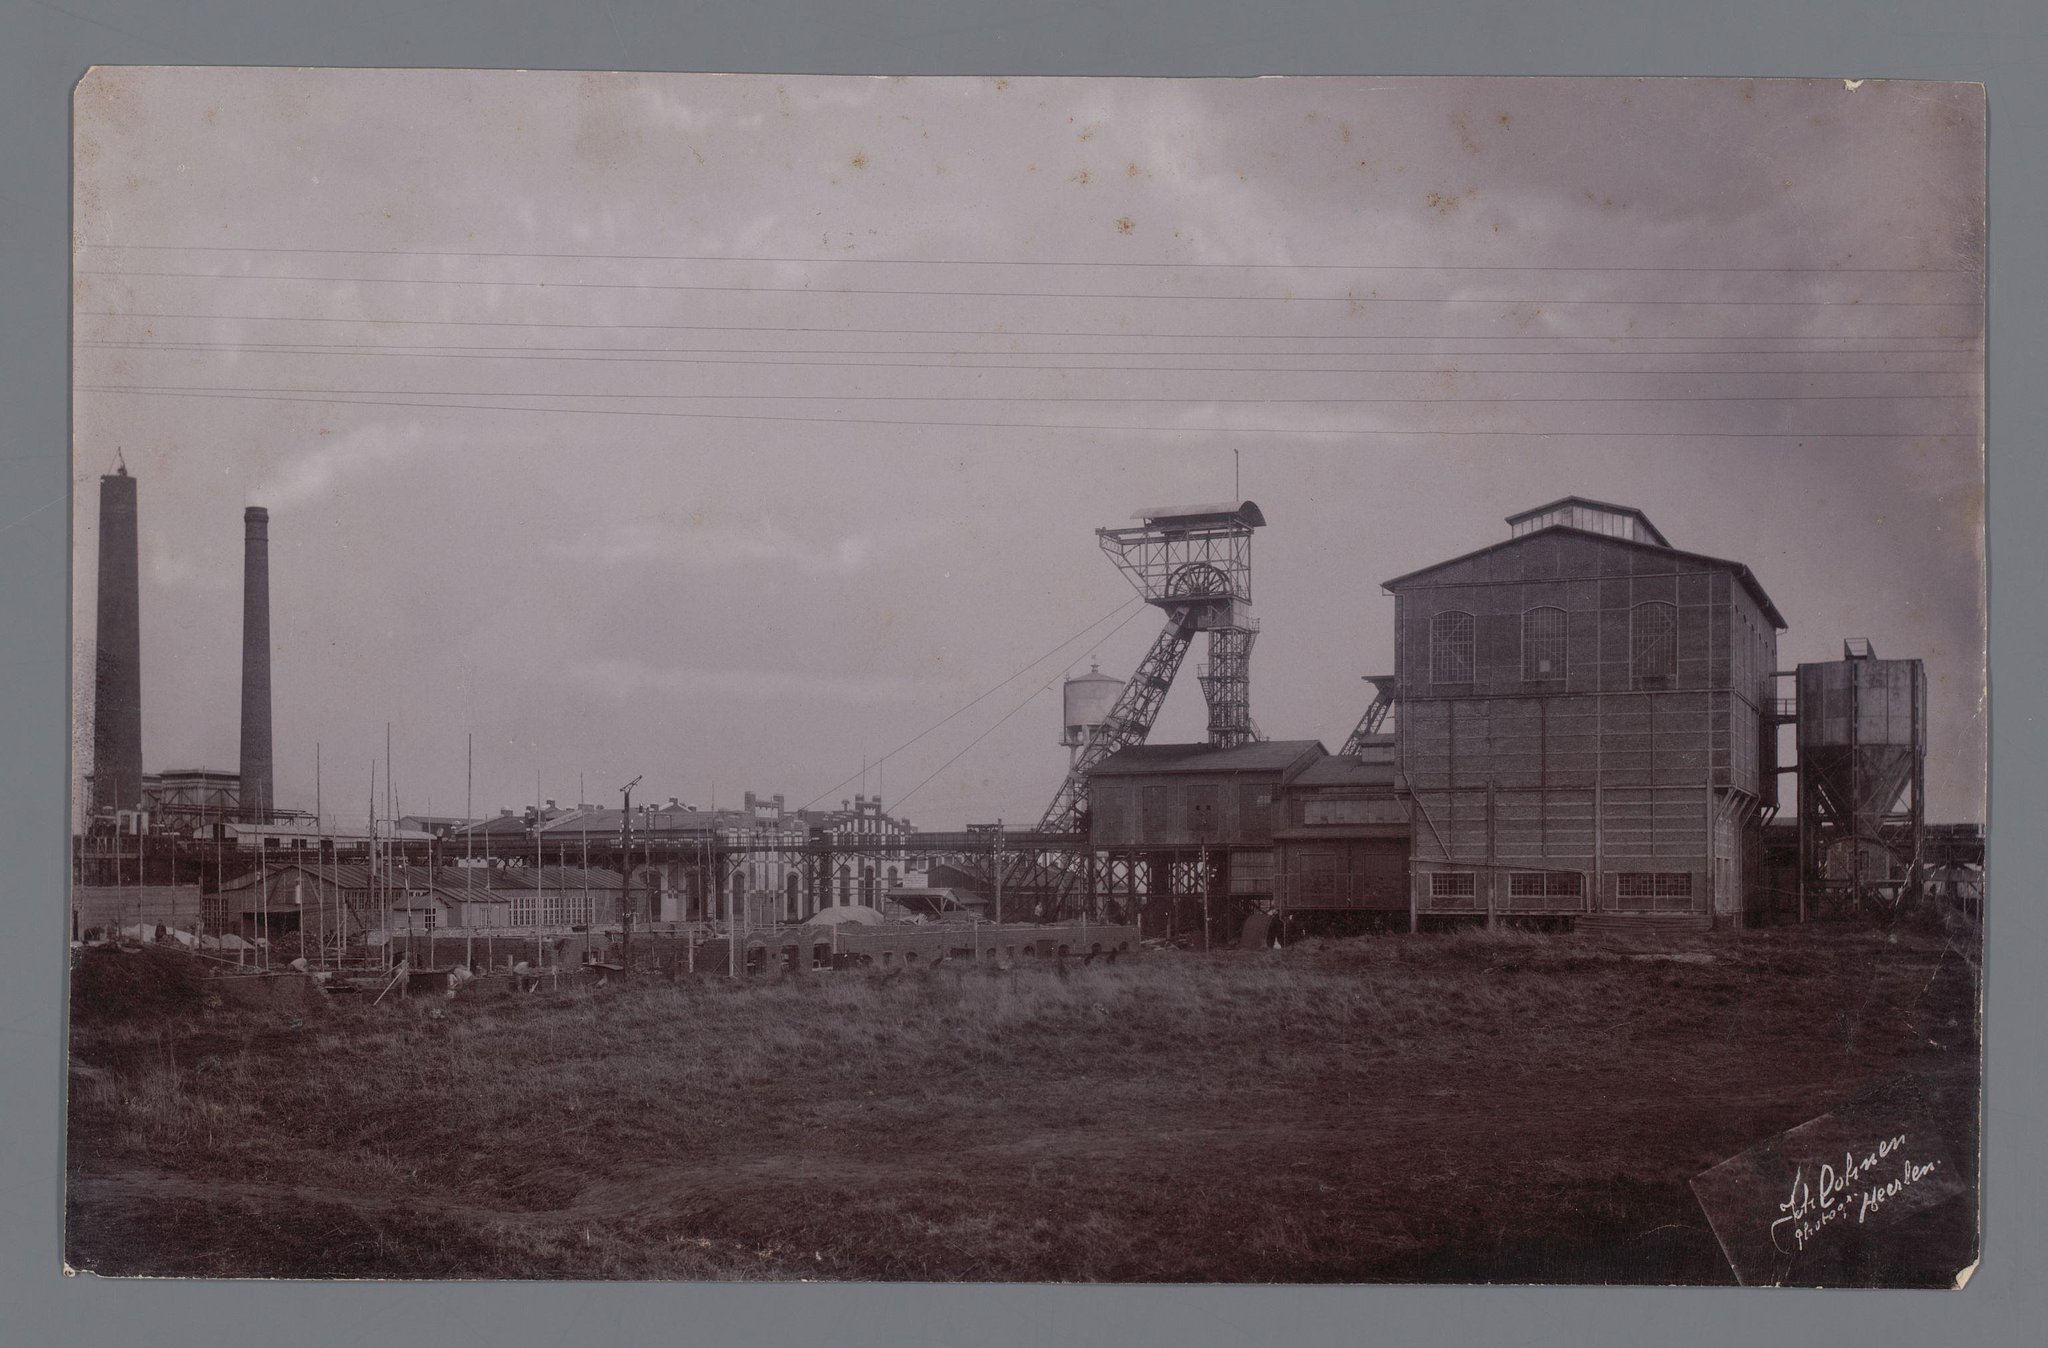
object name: photograph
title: Gezicht op een steenkolenmijn in Limburg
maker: johan joachim cohnen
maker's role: publisher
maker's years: 1885-1947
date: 1906-1920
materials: cardboard, paper, photographic support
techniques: collodion silver print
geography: heerlen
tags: terwinselen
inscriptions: signature: ‘Joh Cohnen Photogr. Heerlen’, annotation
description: Gezicht op Staatsmijn Wilhelmina in Terwinselen, Limburg.